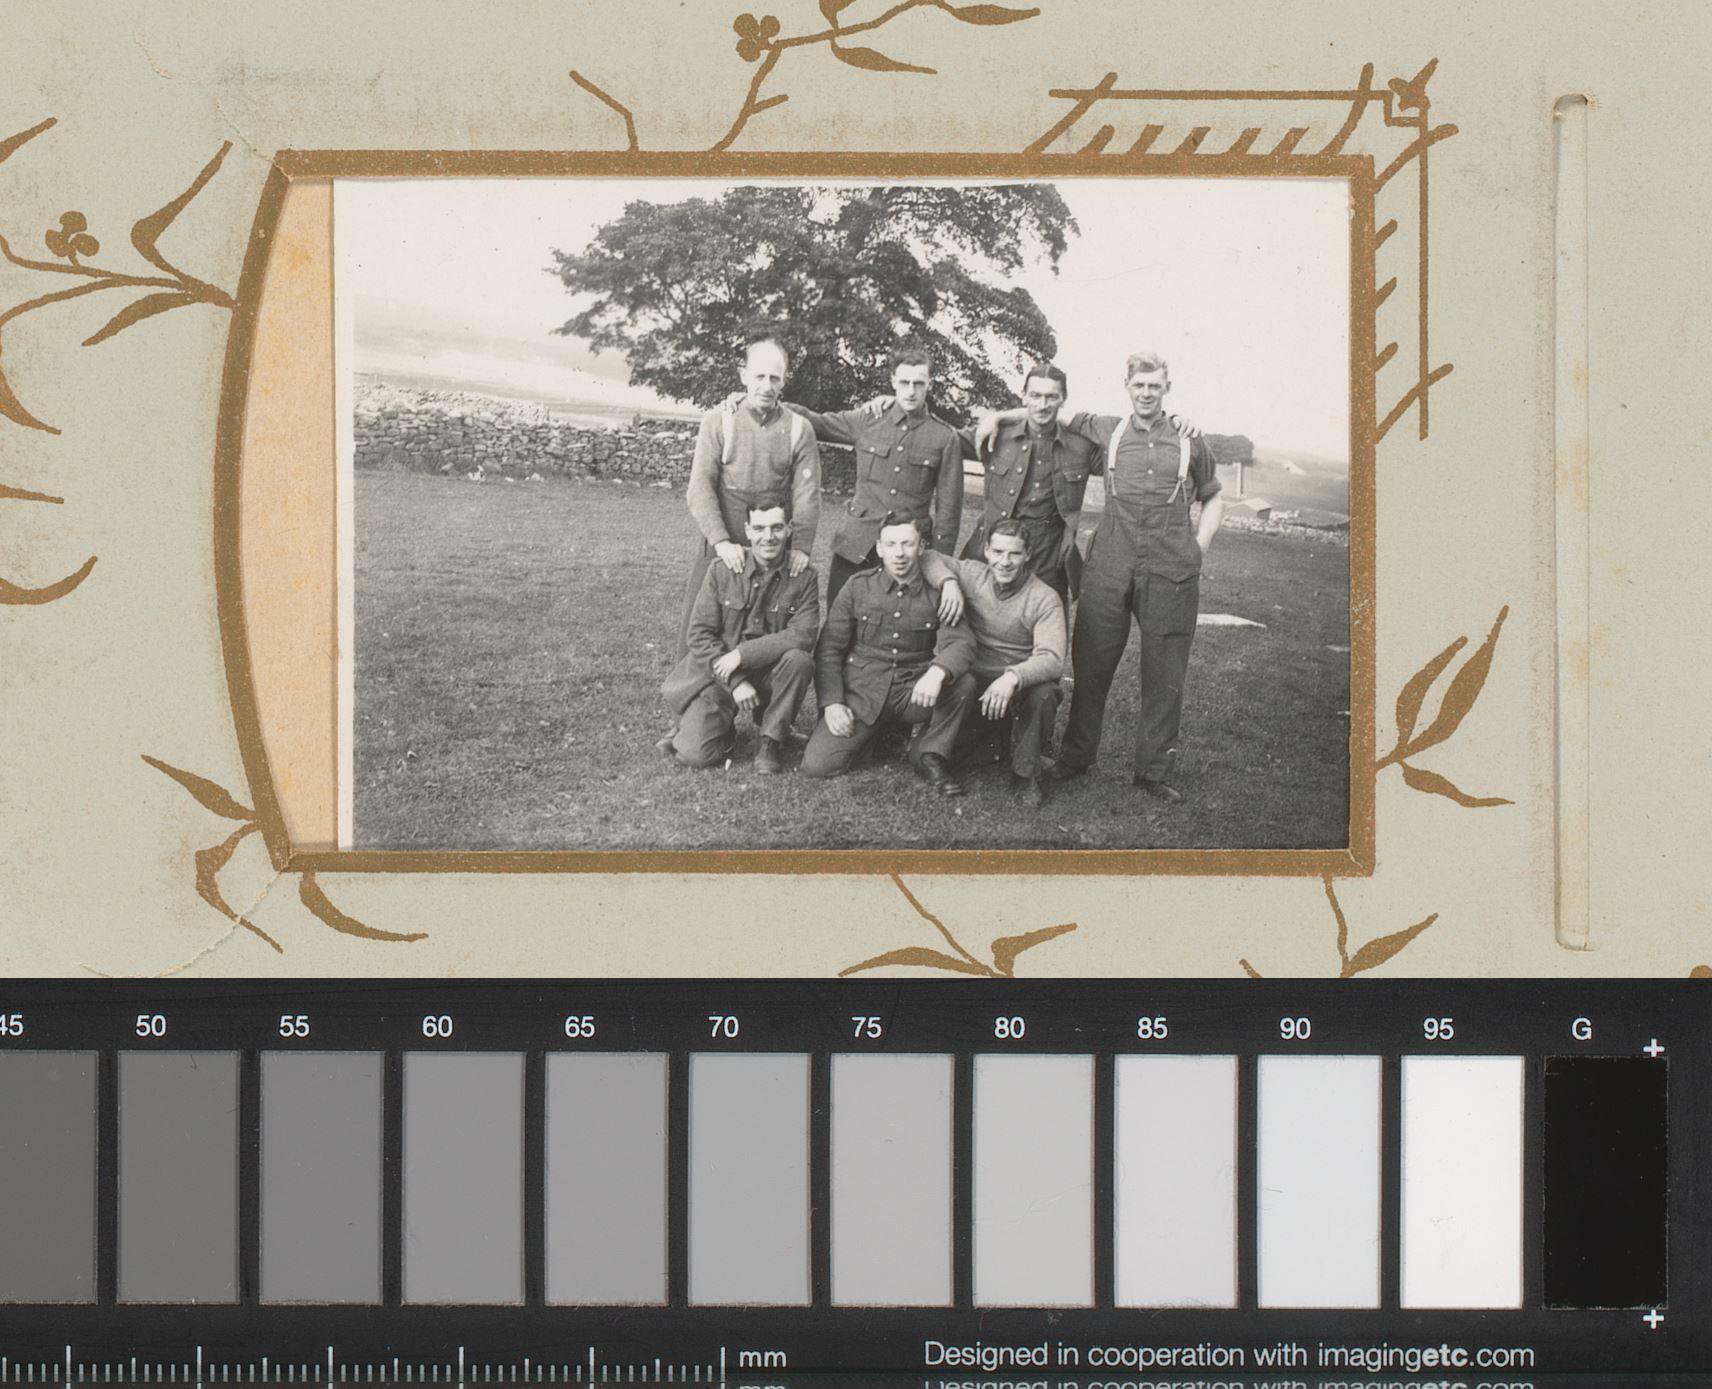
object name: album leaf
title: Groepsportret van militairen in uniform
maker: Anonymous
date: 1899-1940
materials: cardboard, photographic support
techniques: gelatin silver print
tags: adult man, (military) uniforms, anonymous historical persons portrayed in a group, in a group-portrait